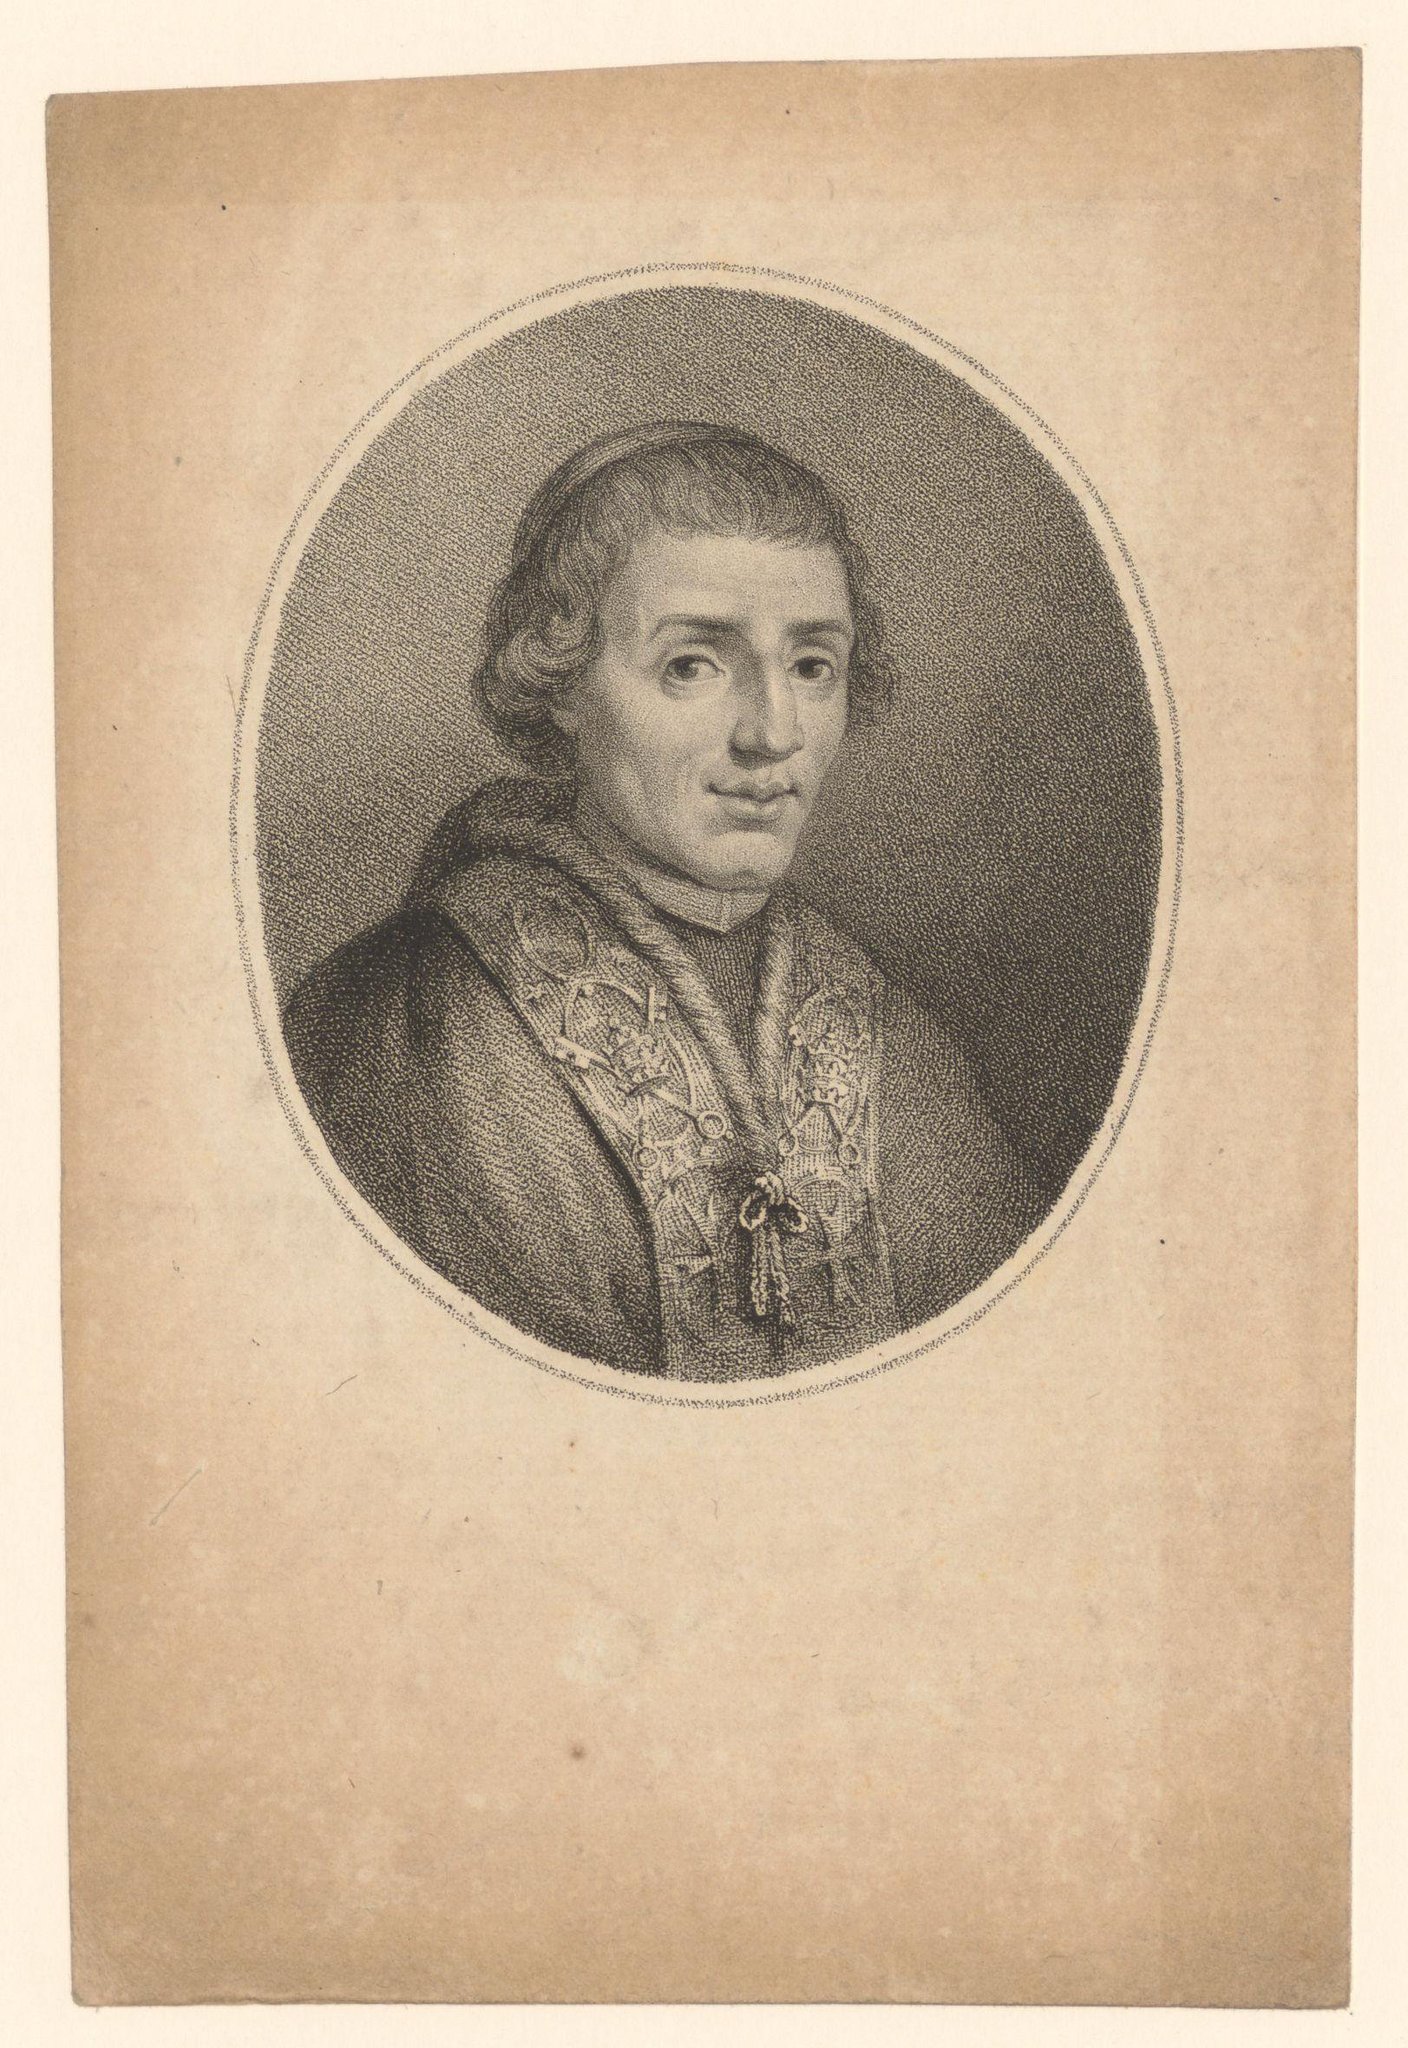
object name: print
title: Portret van paus Pius VII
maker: george keating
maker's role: print maker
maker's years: 1762-1842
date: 1772-1800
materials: paper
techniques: etching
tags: rome, clergyman, pius vii, historical persons, pope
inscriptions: collector's mark: Lugt 2228